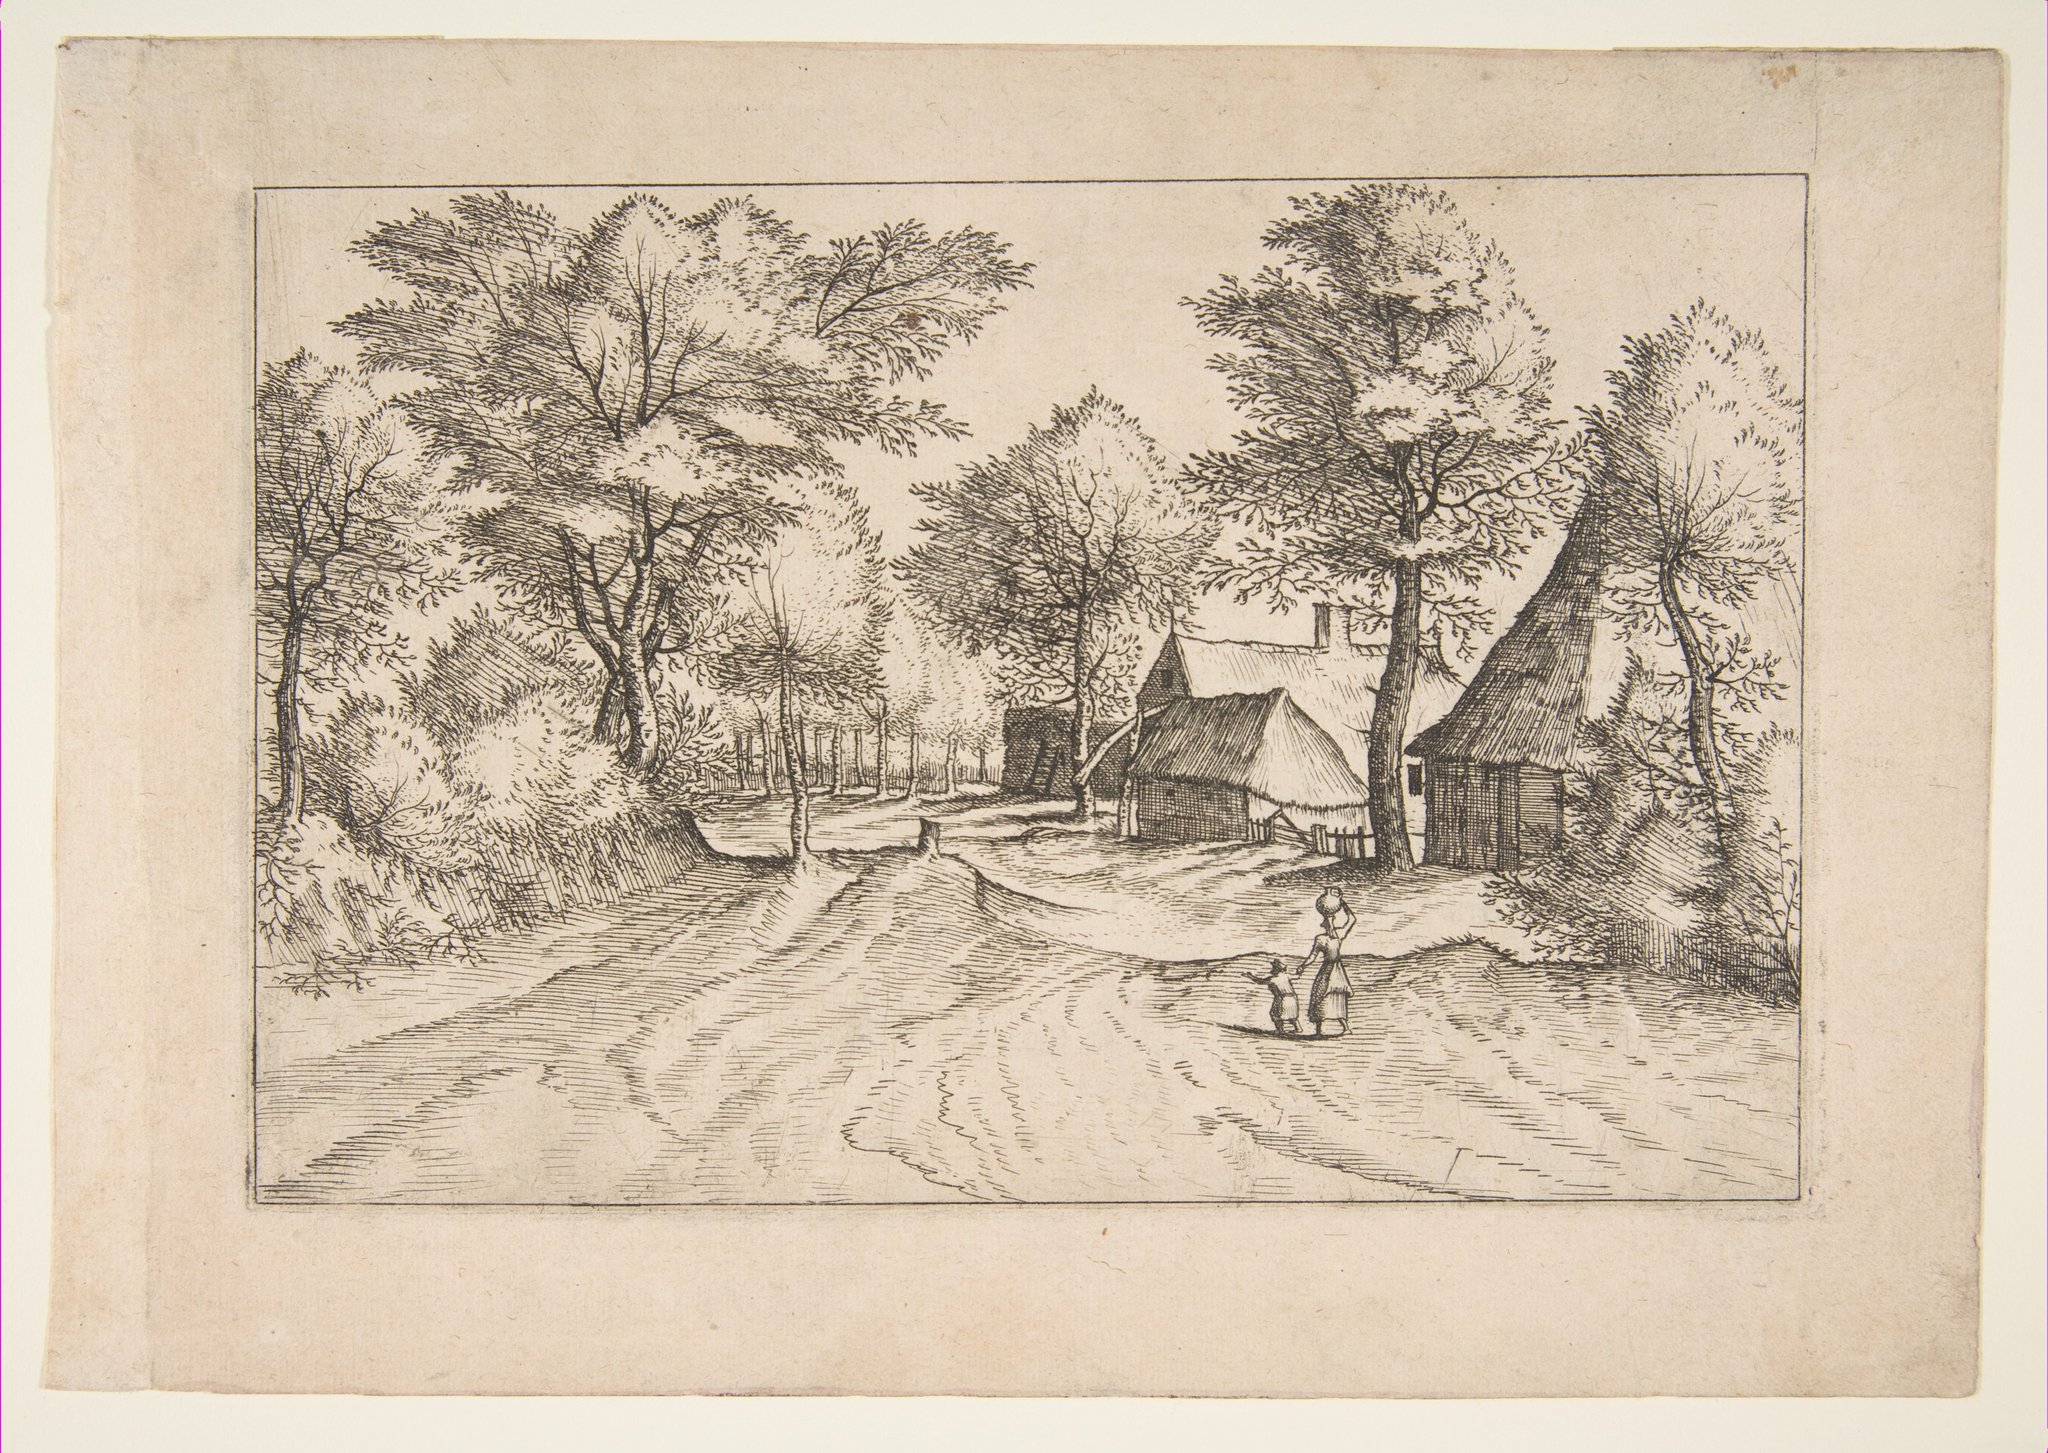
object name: print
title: Village Road with a Farm and Sheds, from the series, The Small Landscapes (Multifariarum Casularum)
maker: johannes van doetecum i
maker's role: artist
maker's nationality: netherlandish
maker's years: 1528-1605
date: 1559-1561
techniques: etching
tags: human figures,roads,farms,villages,landscapes